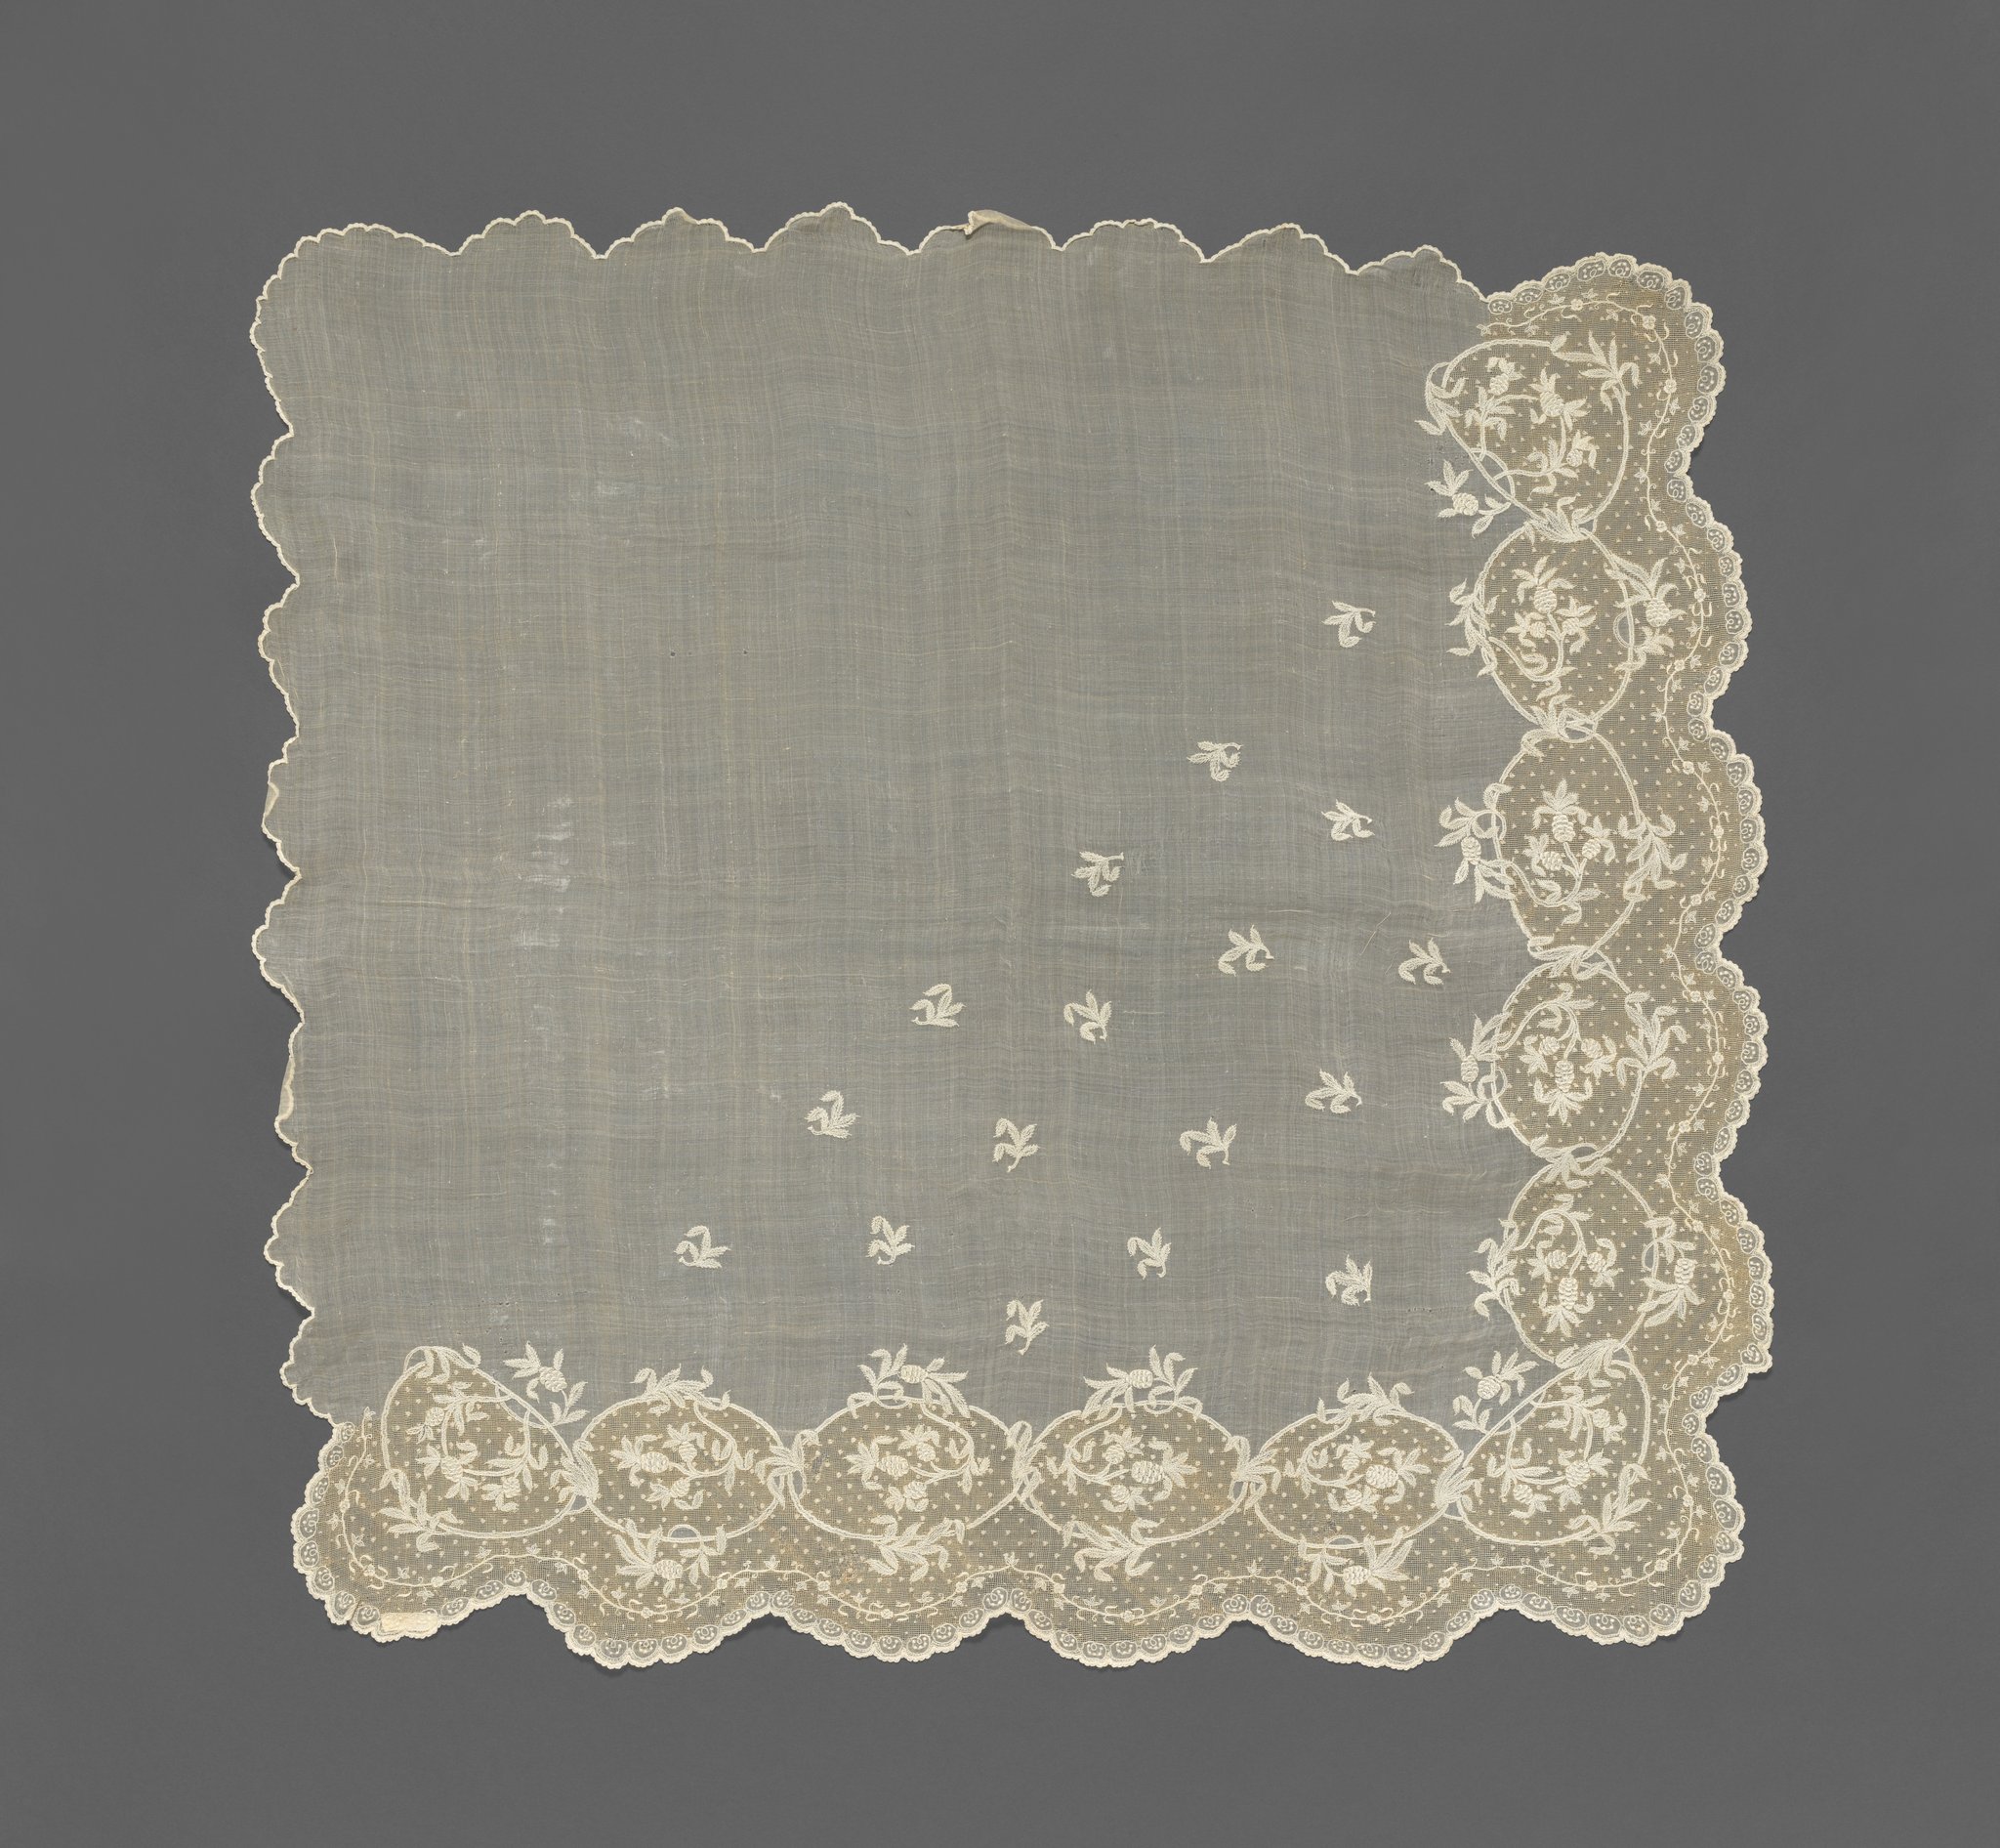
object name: kerchief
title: Kerchief (Pañuelo)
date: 1801-1850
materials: fiber, linen